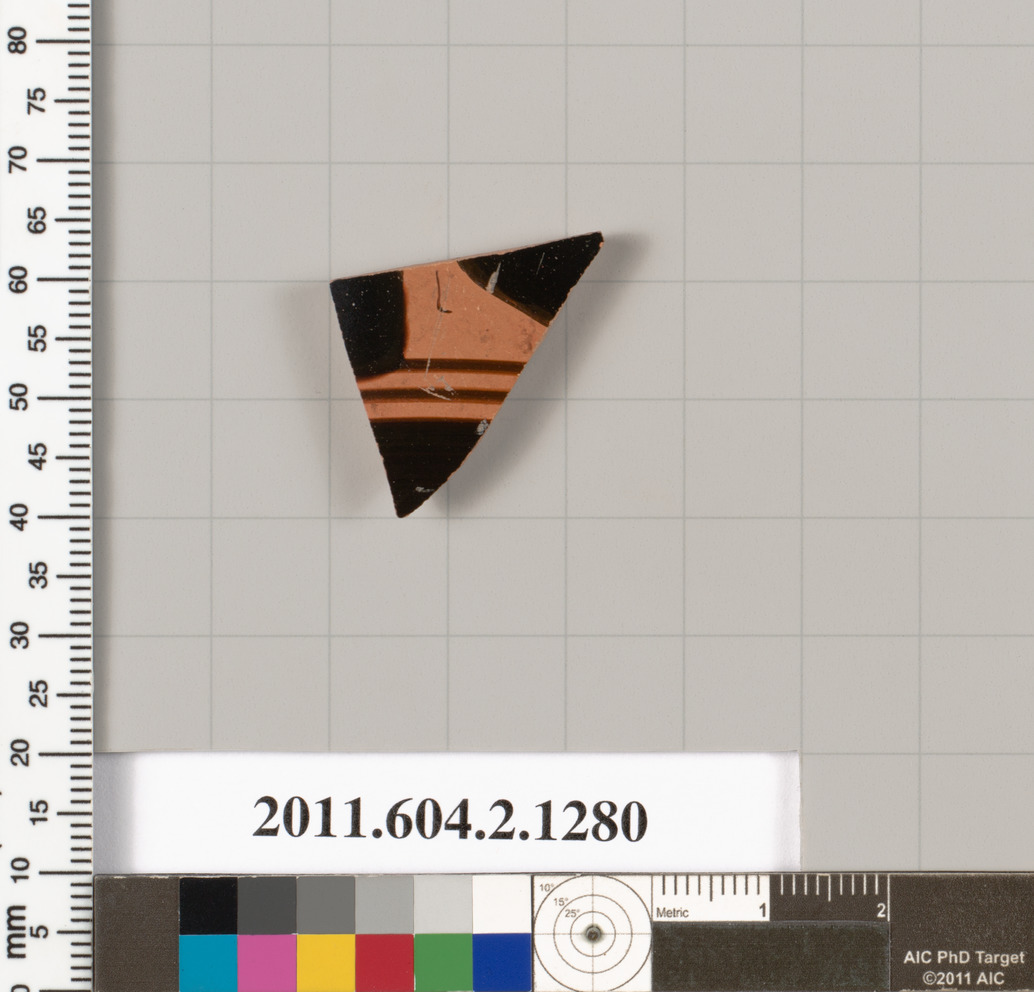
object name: skyphos fragment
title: Terracotta fragment of a skyphos (deep drinking cup)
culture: greek, attic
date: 475-451 BCE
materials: terracotta